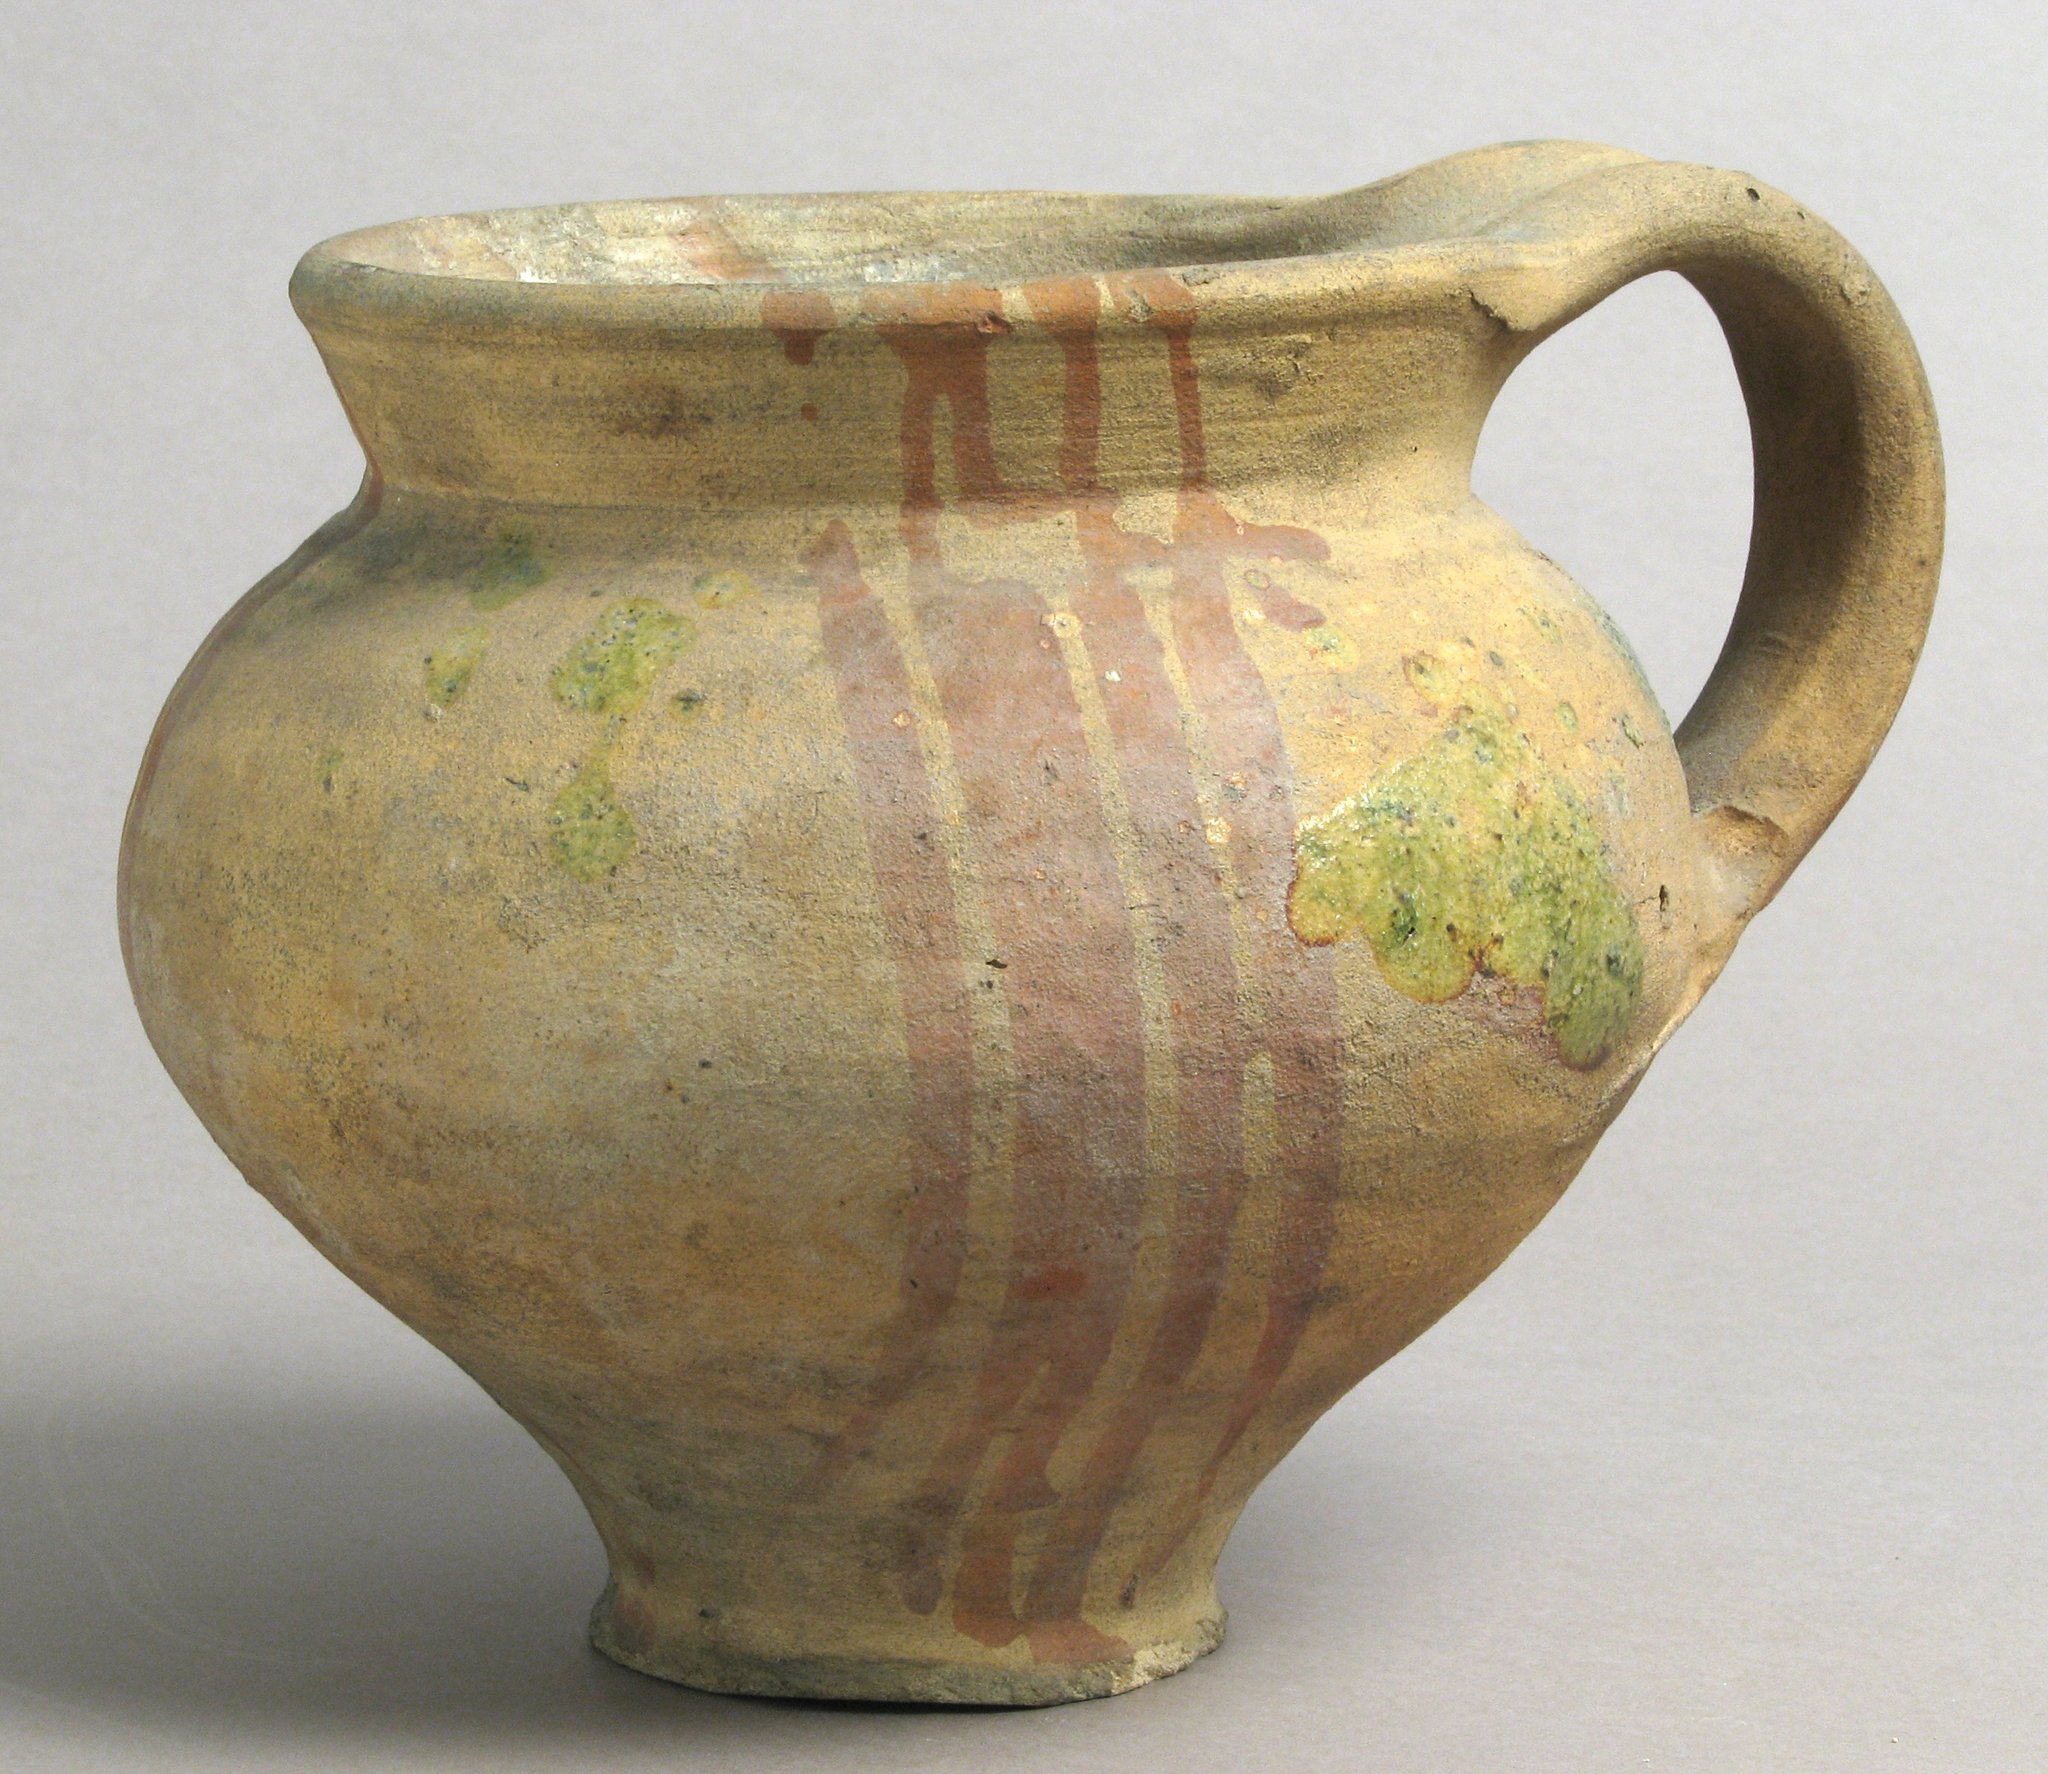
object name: jar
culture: french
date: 1201-1400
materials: earthenware, glaze